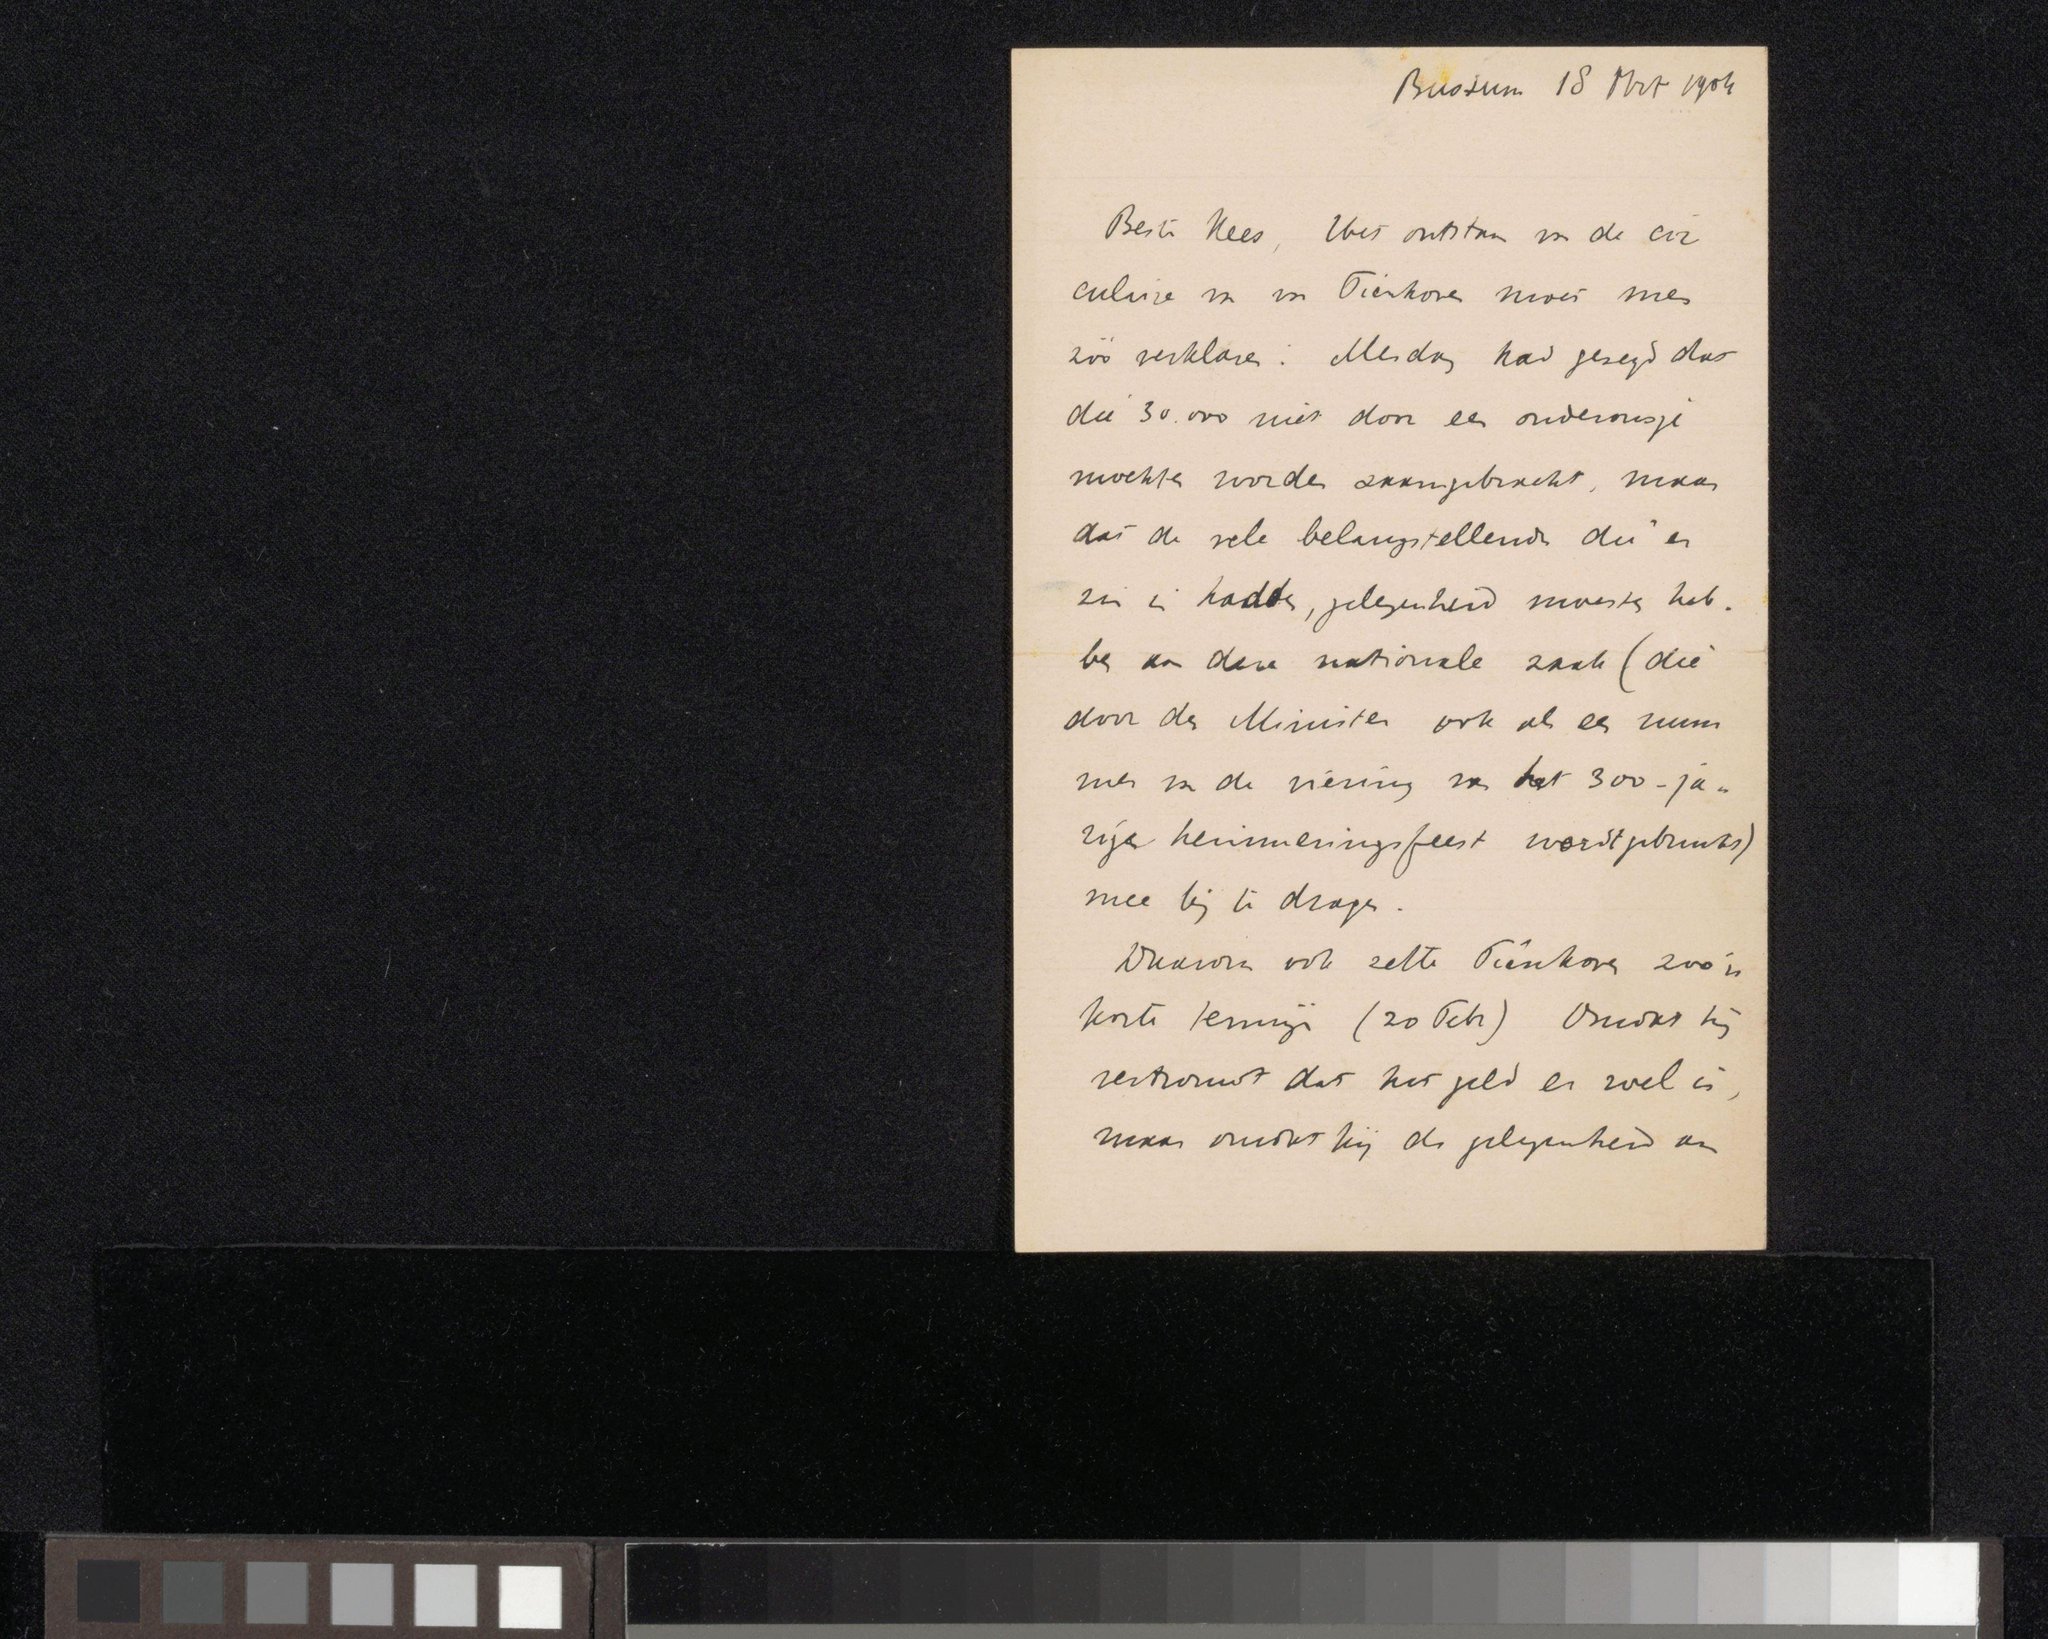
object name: letter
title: Brief aan Cornelis Gerardus 't Hooft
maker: jan veth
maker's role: designer, draughtsman, painter, print maker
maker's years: 1864-1925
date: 1904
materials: ink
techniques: pen, writing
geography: bussum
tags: print maker, hendrik willem mesdag, mayor, gijsbert van tienhoven, dordrecht, amsterdam, painter, draughtsman, cornelis gerardus 't hooft, money, printed matter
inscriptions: collector's mark: ‘RPK’, watermark